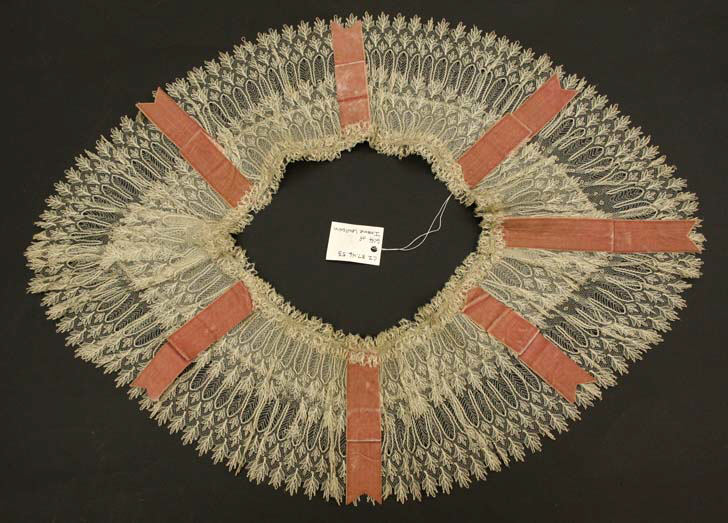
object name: bertha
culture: british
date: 1700-1937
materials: silk